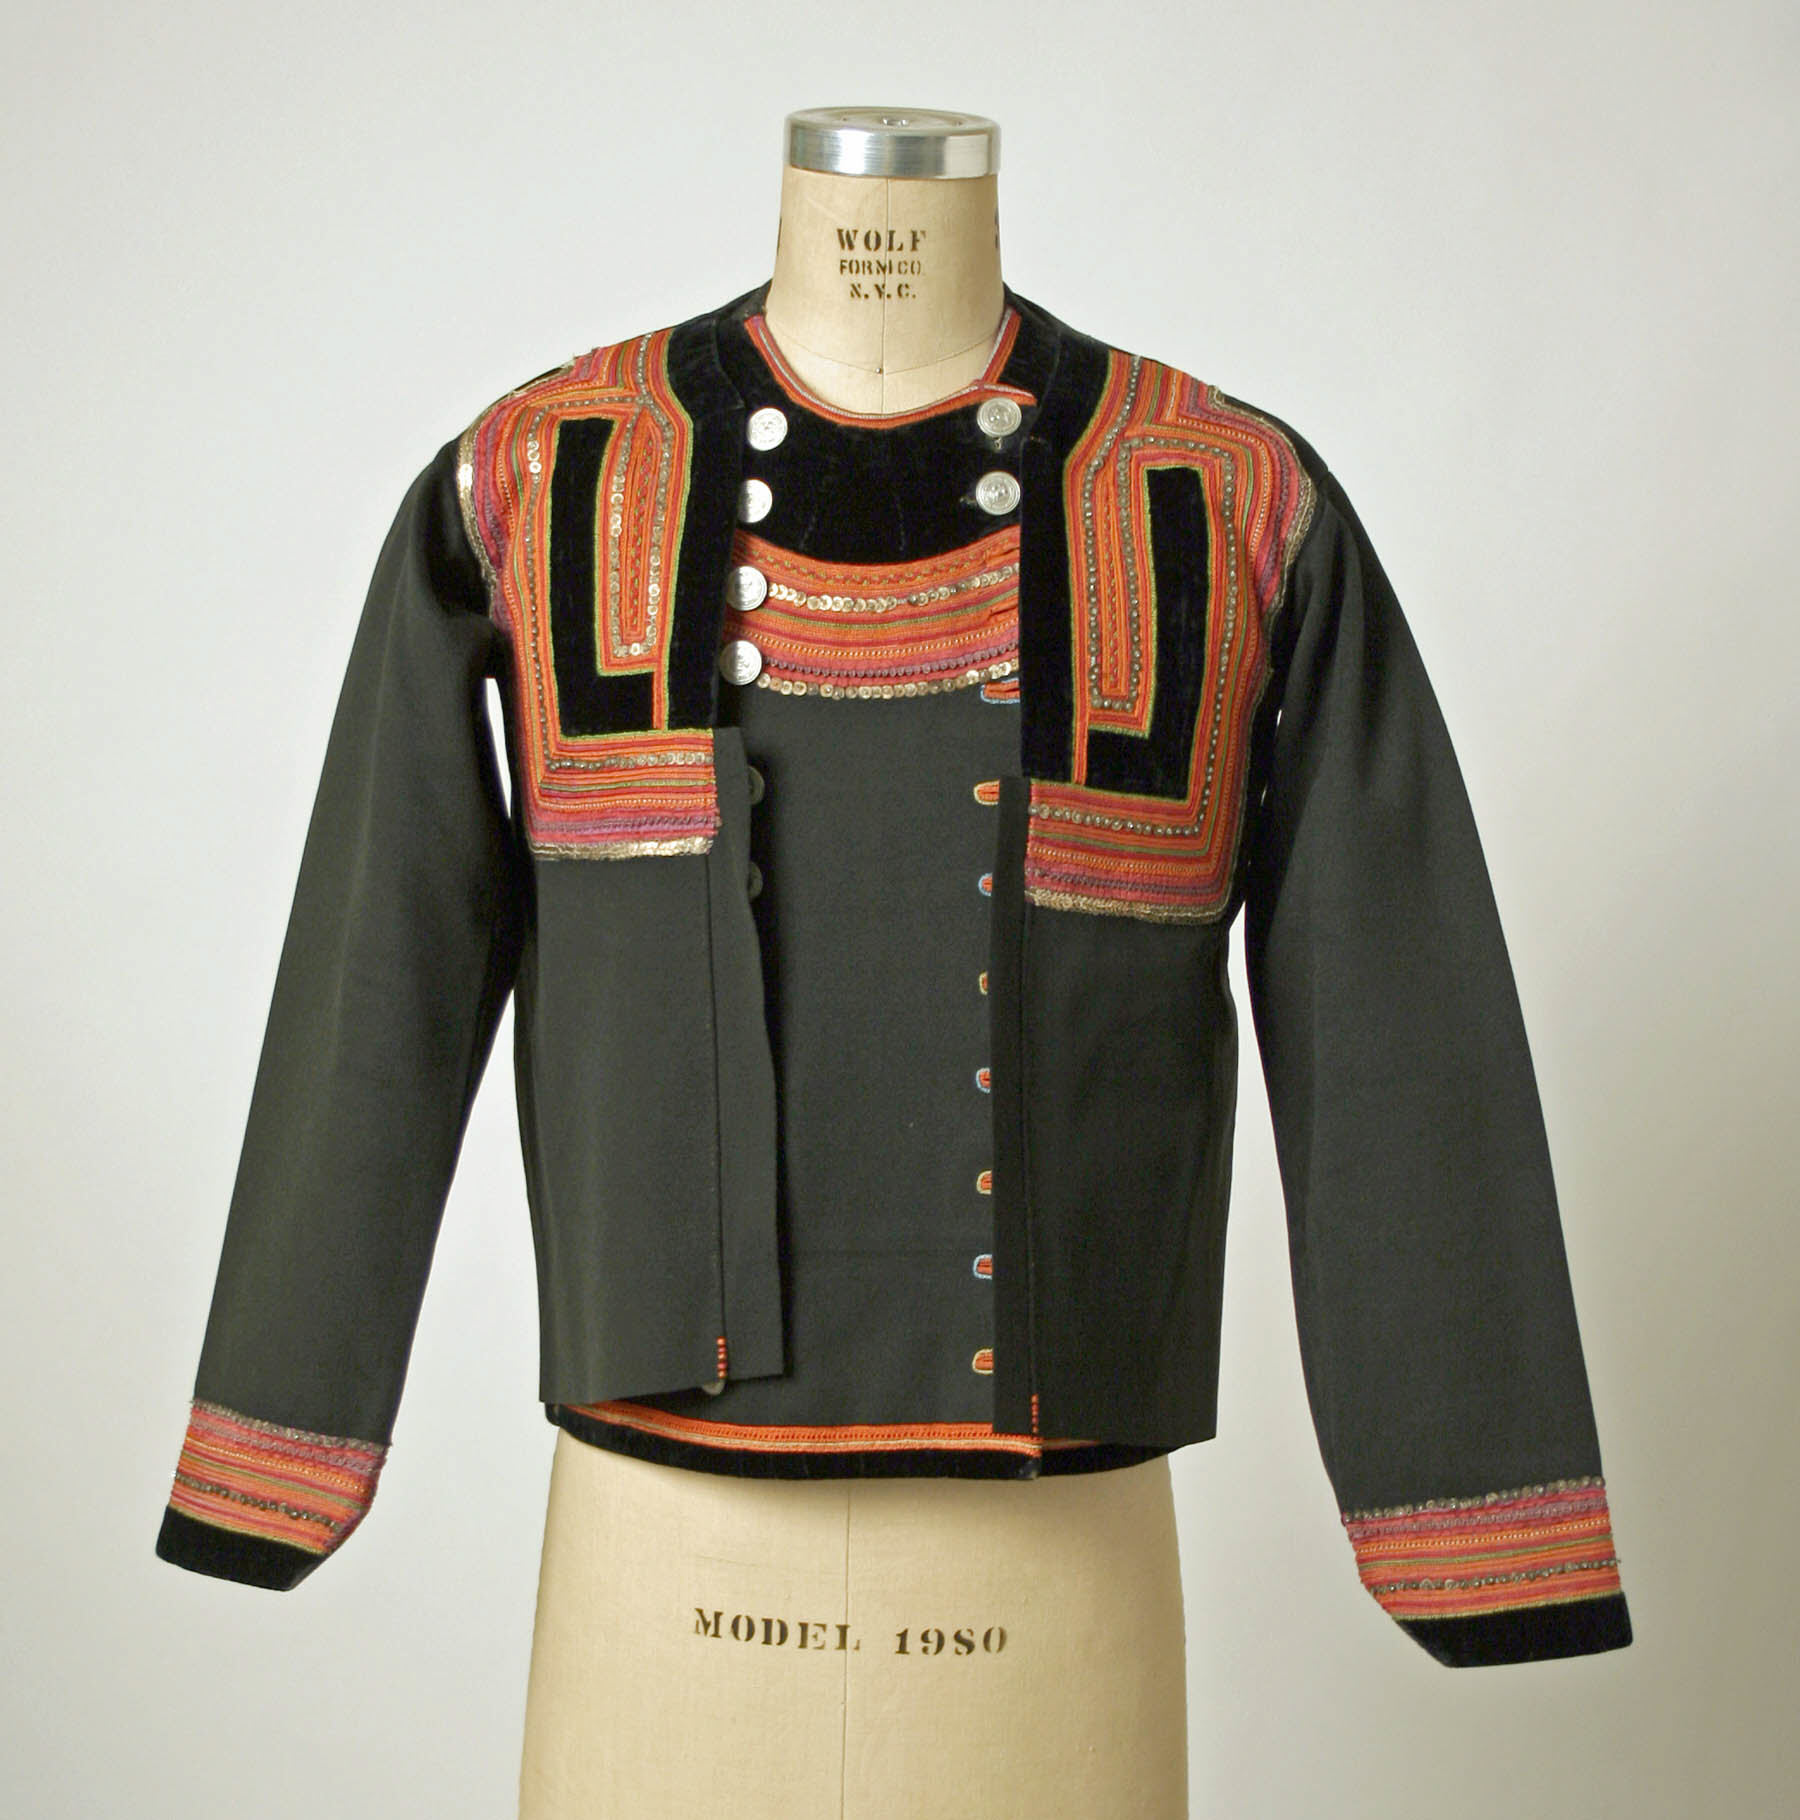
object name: jacket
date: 1801-1900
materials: silk, wool